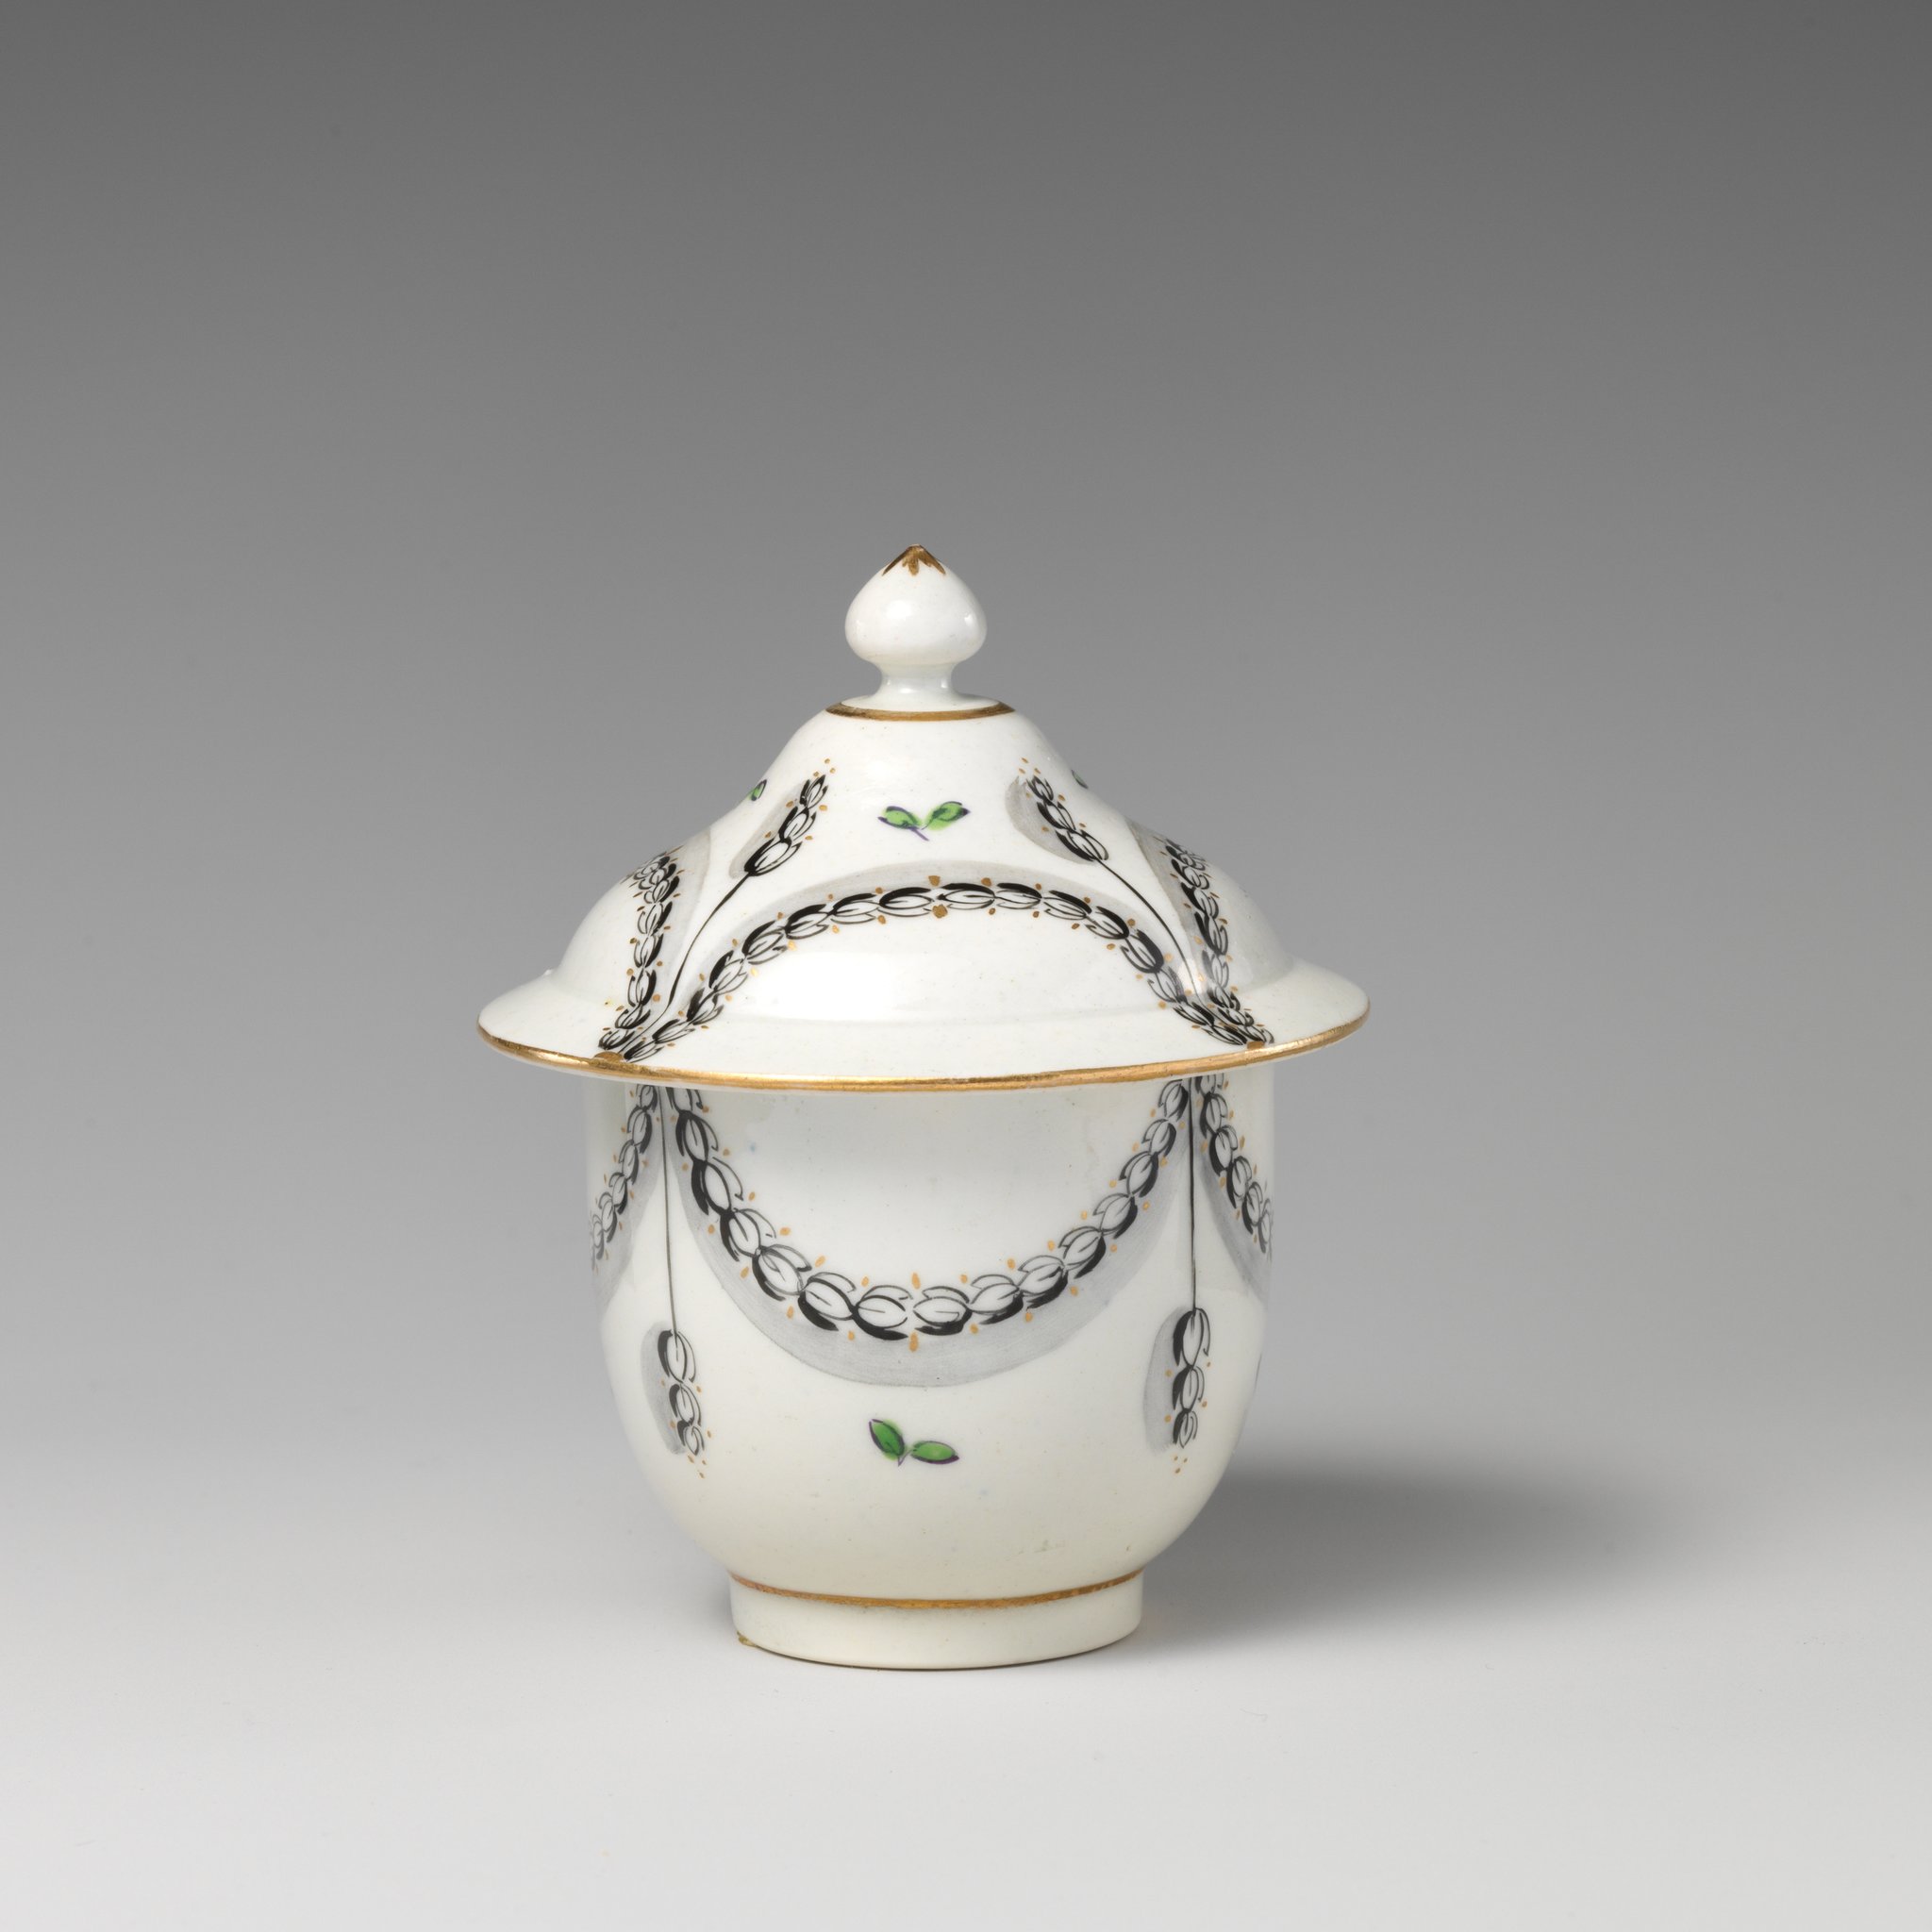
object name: sugar bowl with cover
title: Sugar bowl with cover (part of a service)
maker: caughley factory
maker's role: factory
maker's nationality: british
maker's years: 1772-1799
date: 1780-1790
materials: enamel, soft paste porcelain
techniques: gilding